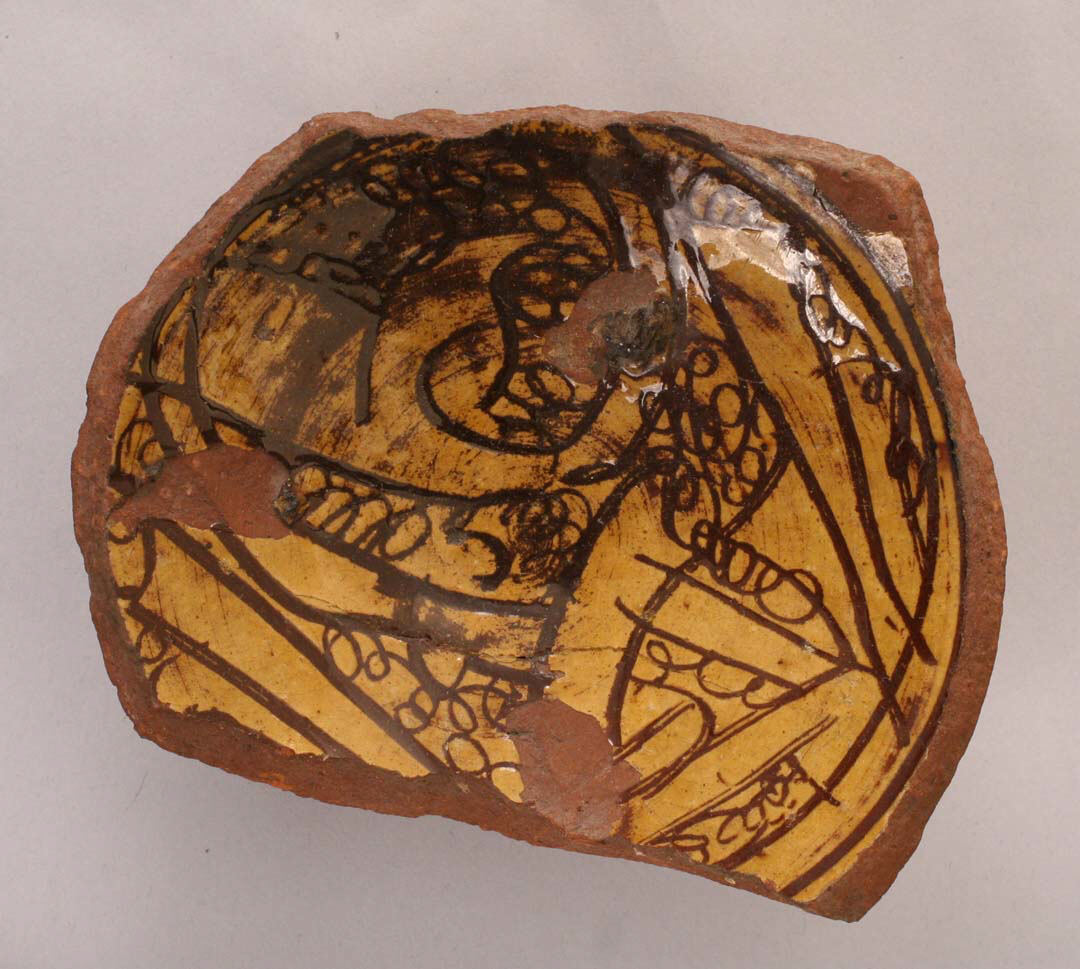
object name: fragment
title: Fragment of a Bowl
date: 1301-1500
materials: earthenware, glaze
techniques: coloring, incising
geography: egypt